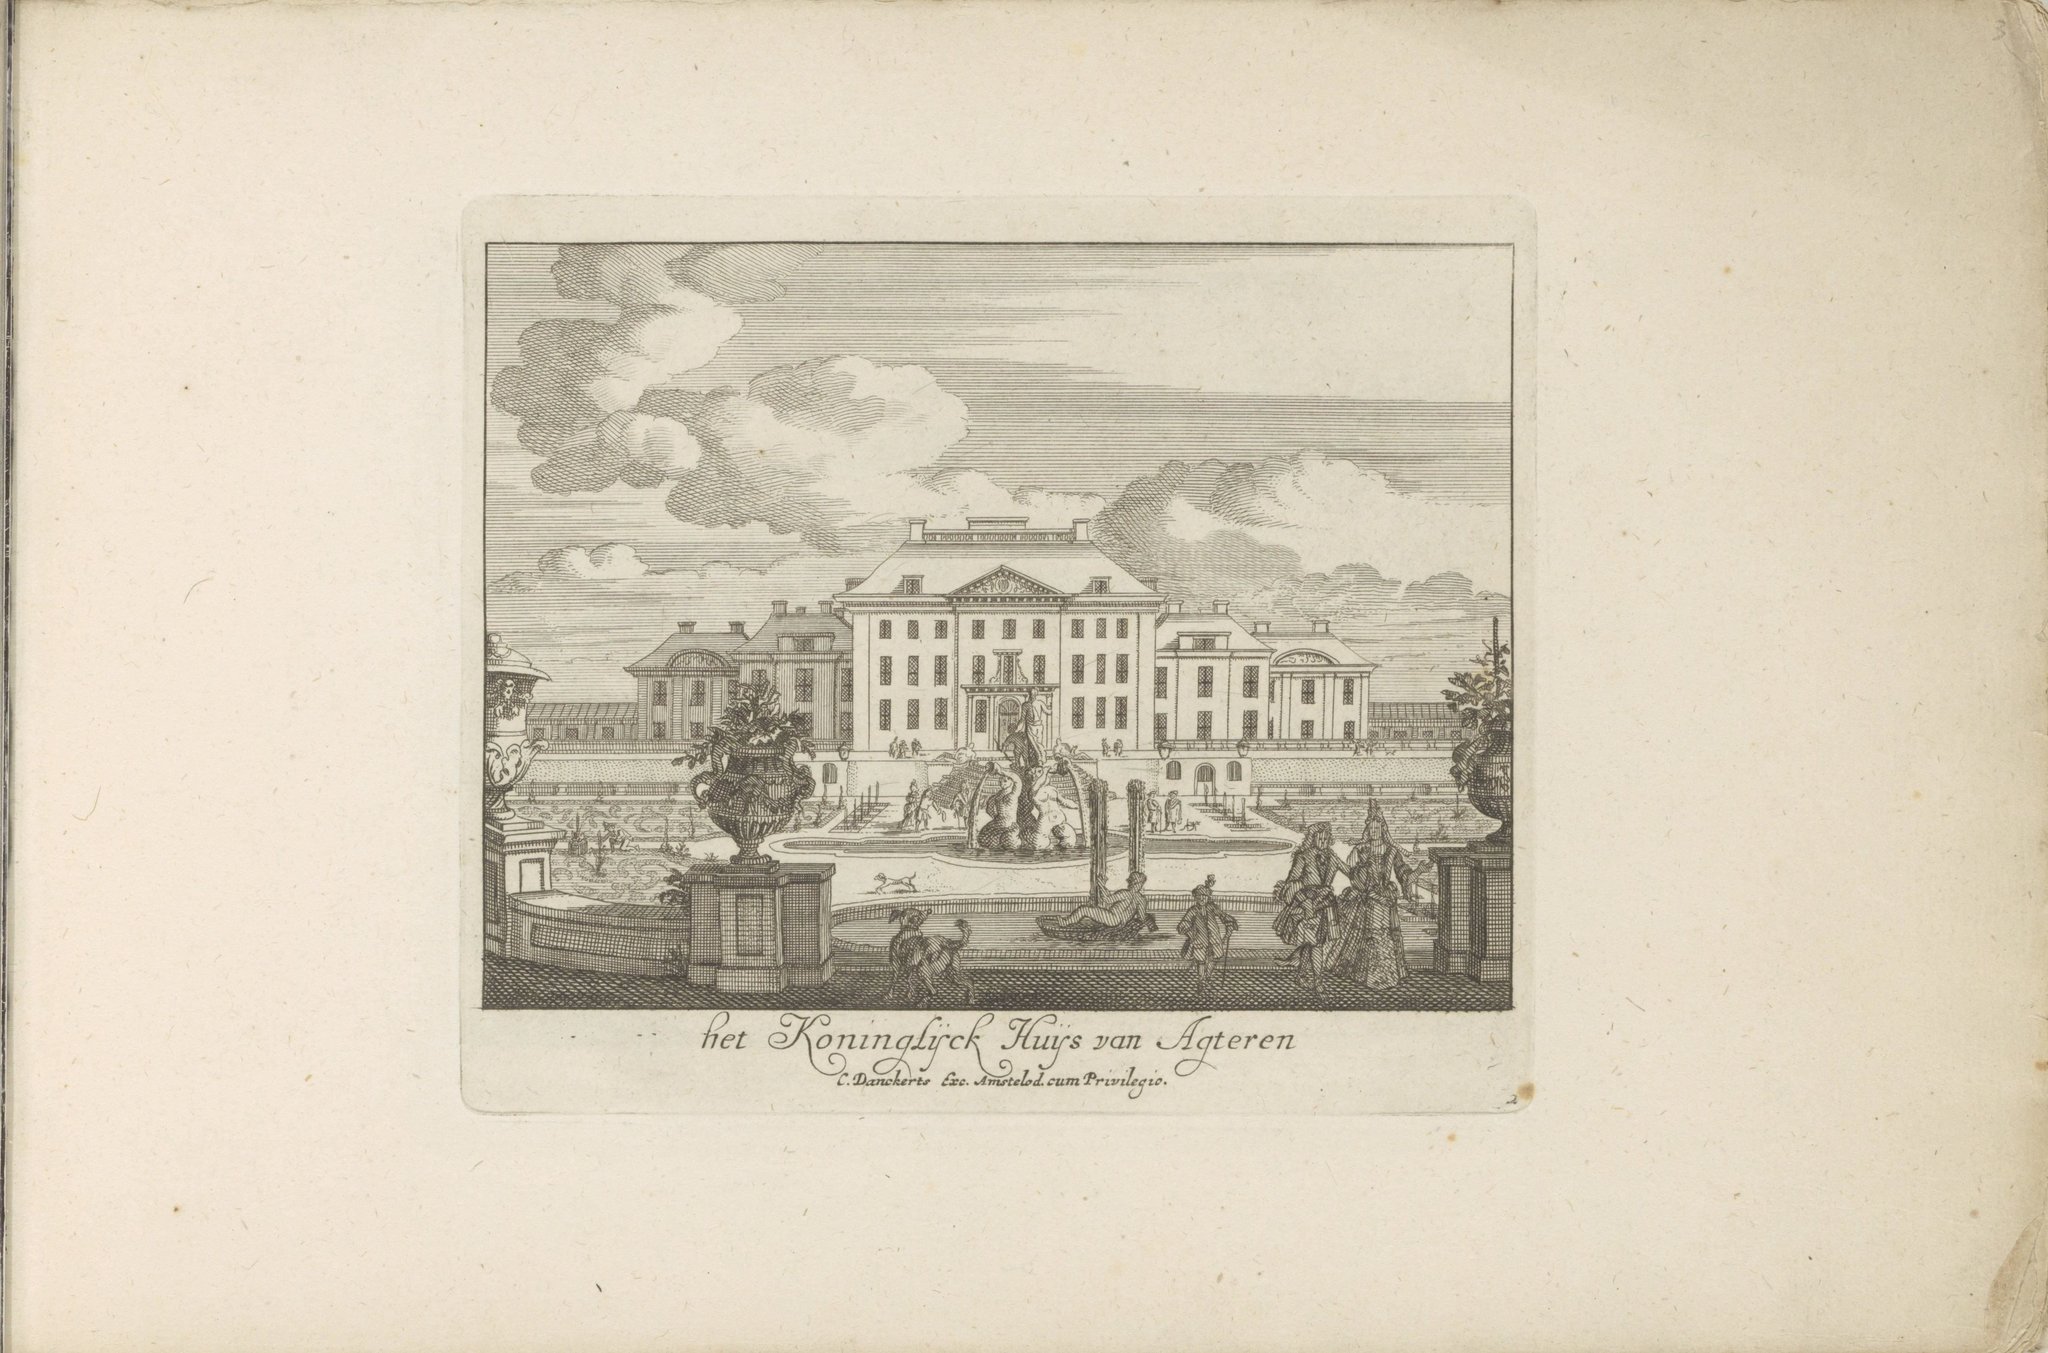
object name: print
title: Nette Afbeeldinge Van de Lust-Tuin, en 't Hof-Gebouw, Van zyn Kooninglyke Majesteit van Groot-Brittanje, enz. enz. enz. Geleegen op 't Loo In Gelderland (...) / Representation au Naturel de Loo En Gueldre. Maison de plaisance de sa Majesté Britannique (...)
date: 1696-1718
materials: paper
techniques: etching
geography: amsterdam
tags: palace, french or architectonic garden; formal garden, ornamental fountain, exterior ~ representation of a building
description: Achteraanzicht van Paleis Het Loo met in de tuin de Venusfontein. Prent maakt deel uit van een album.